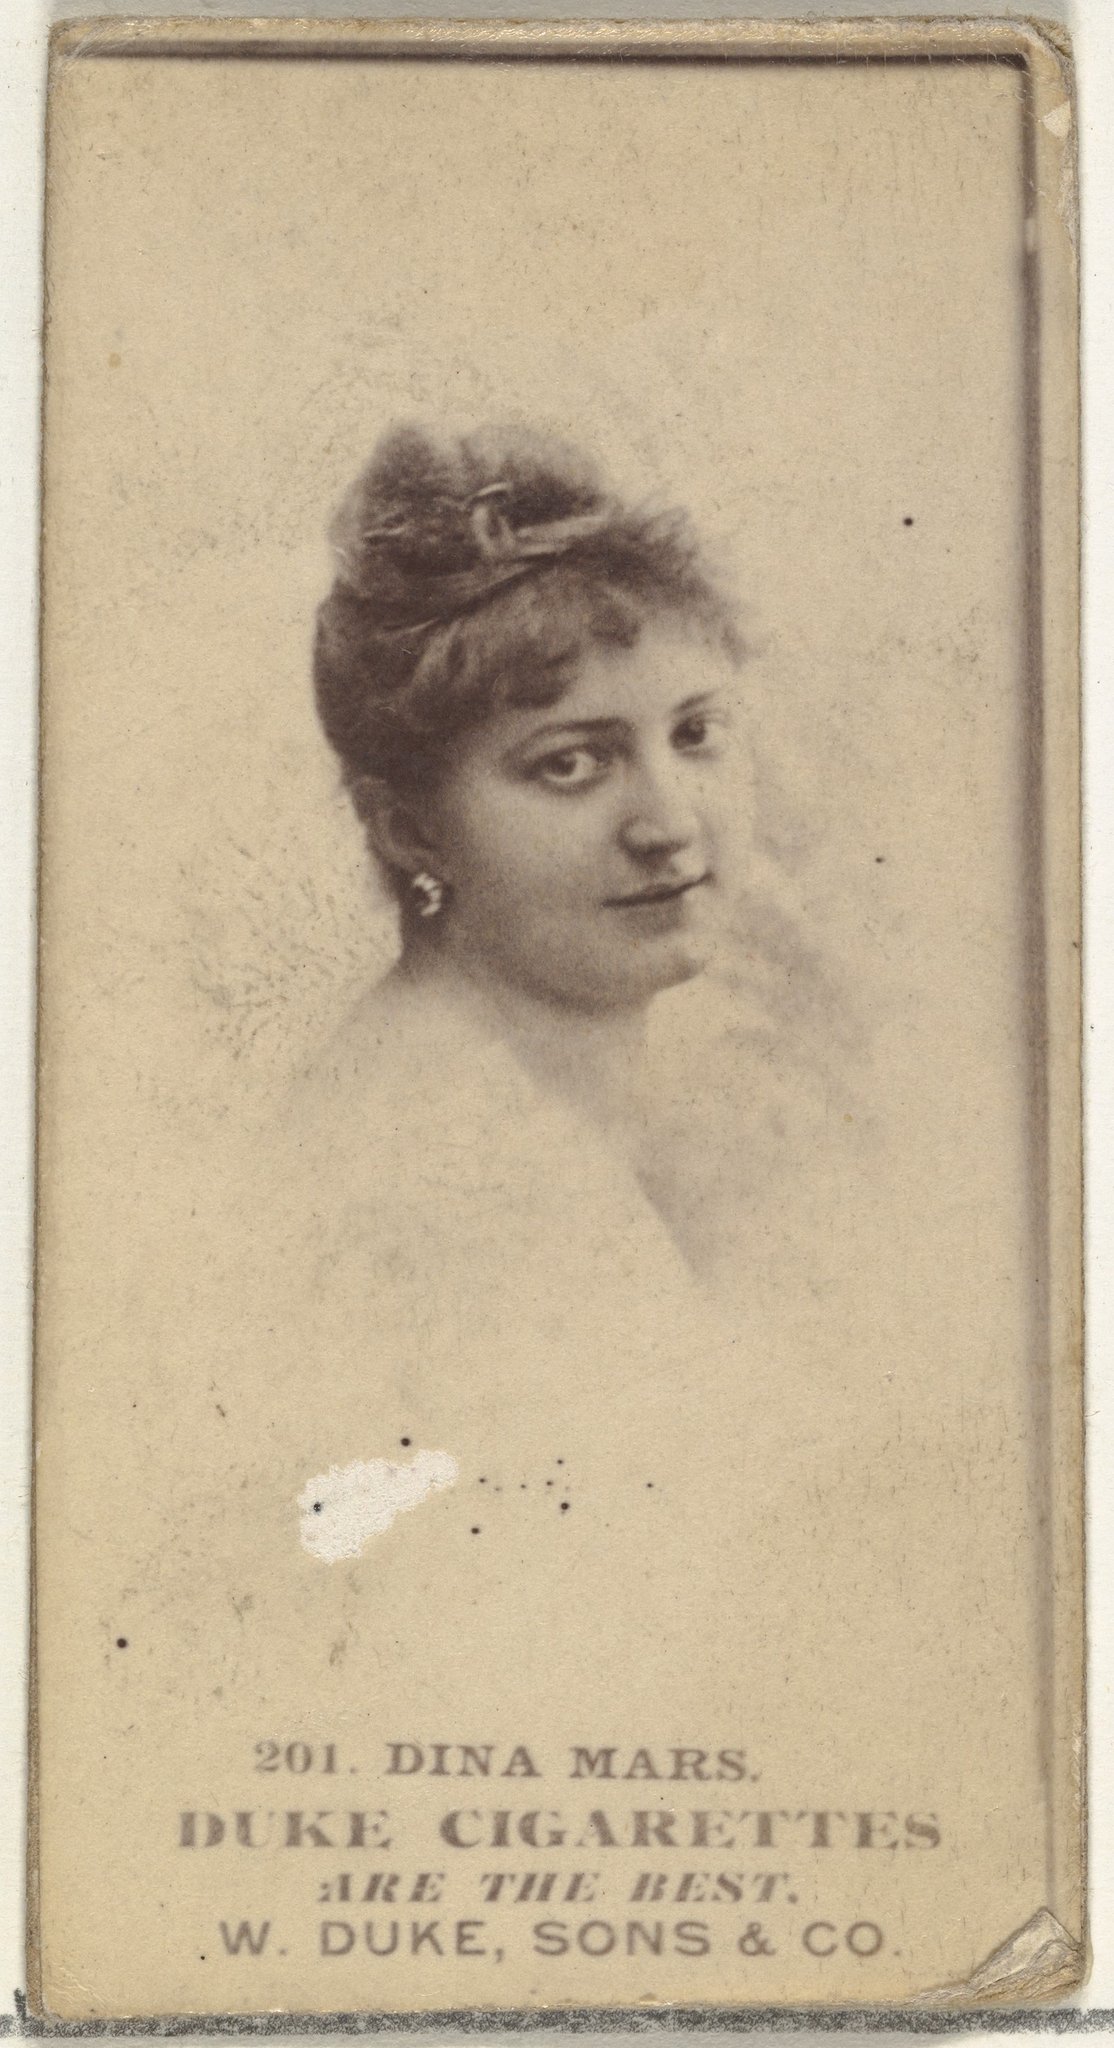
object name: photograph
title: Card Number 201, Dina Mars, from the Actors and Actresses series (N145-7) issued by Duke Sons & Co. to promote Duke Cigarettes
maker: w. duke, sons & co.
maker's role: publisher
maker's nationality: american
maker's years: 1870-1920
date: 1880-1889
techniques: albumen silver print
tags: portraits,women,actresses